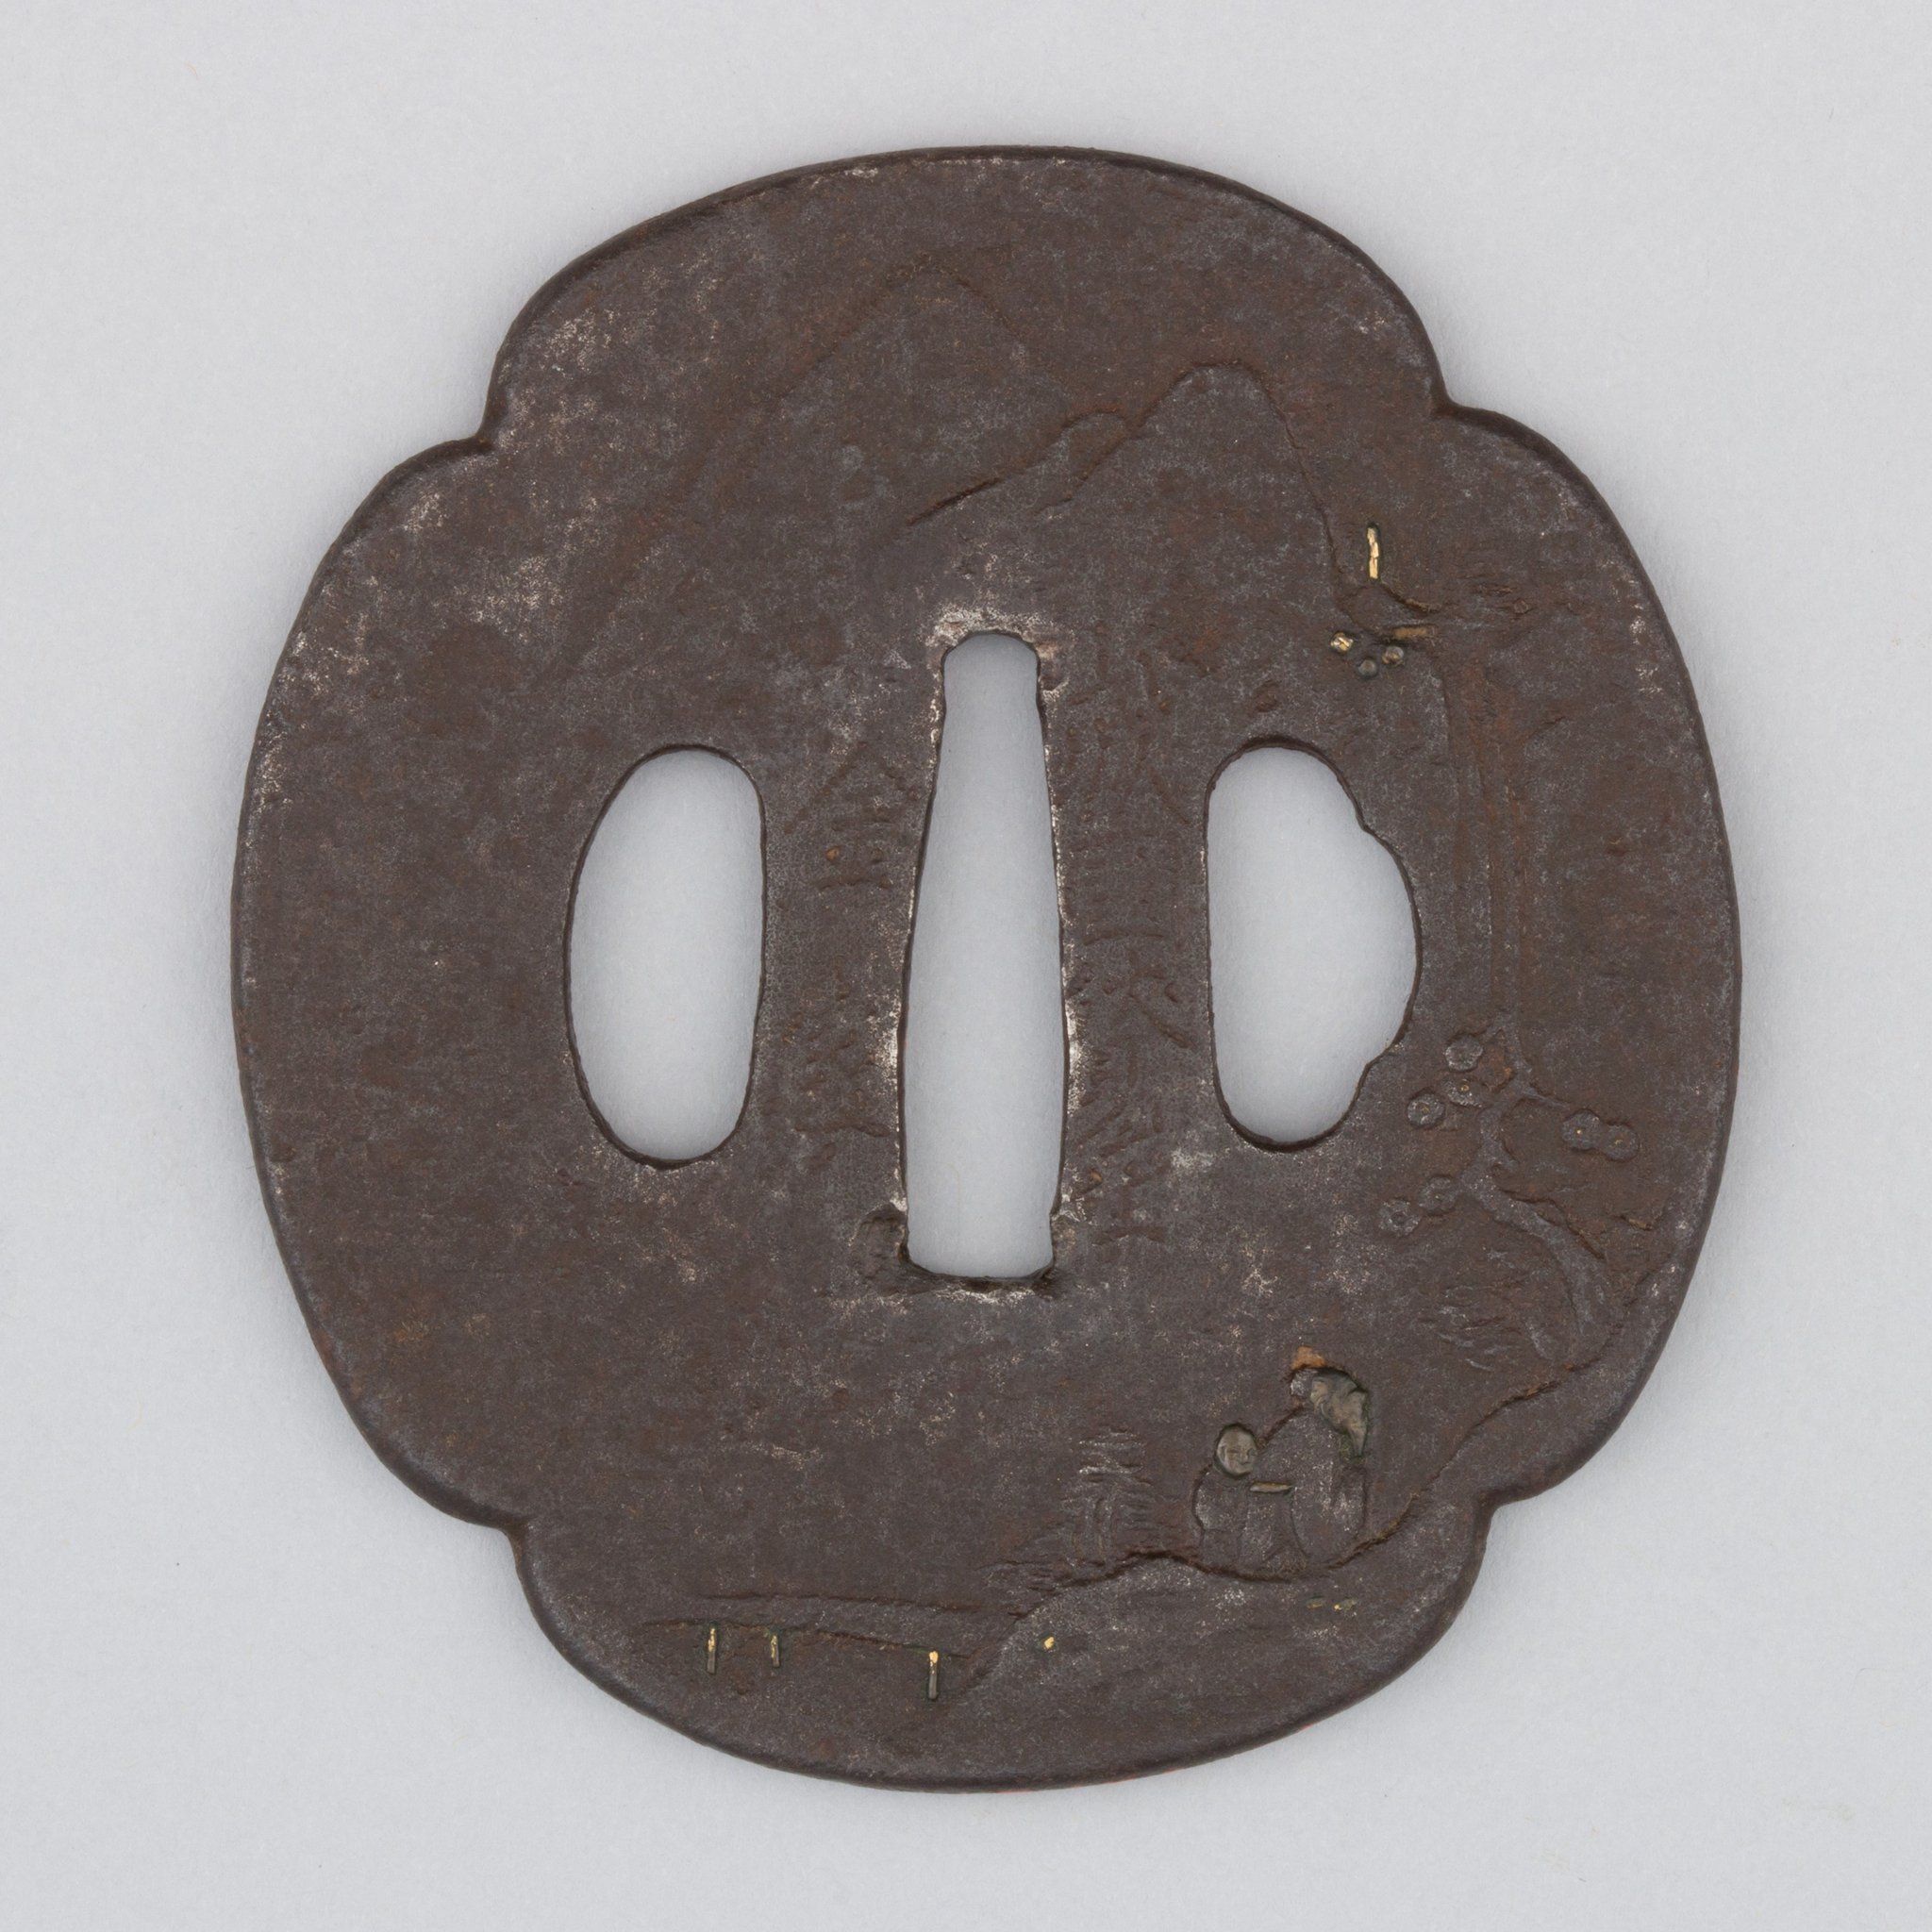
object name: sword guard tsuba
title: Sword Guard (Tsuba)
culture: japanese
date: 1667-1700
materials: copper, iron, silver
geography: japan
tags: children,men